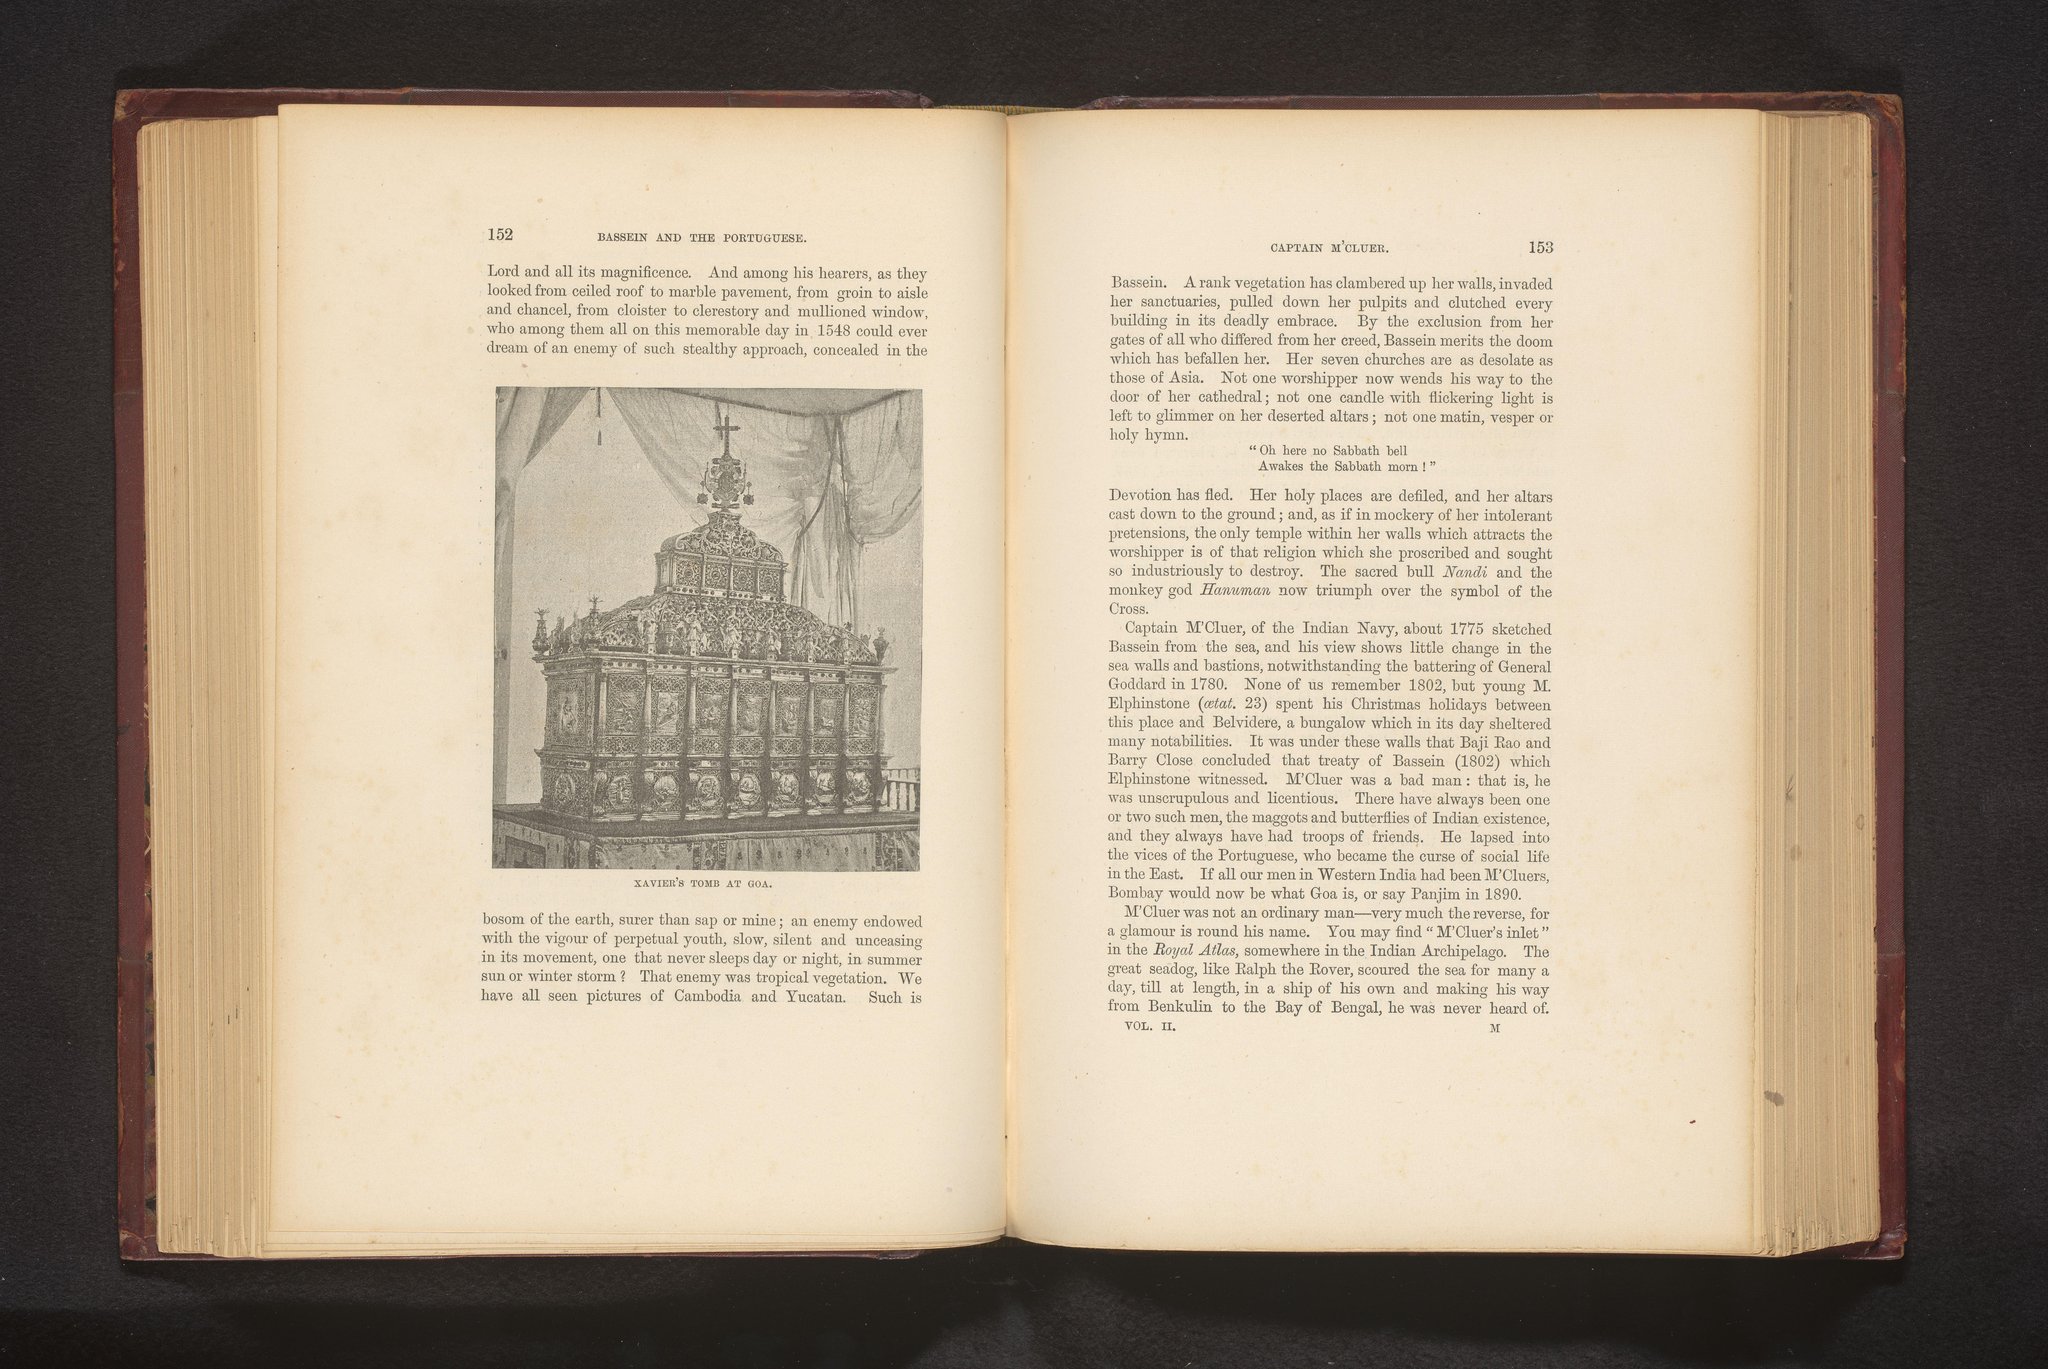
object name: page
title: Xavier's tomb at Goa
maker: Anonymous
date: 1883-1893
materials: paper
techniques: photolithography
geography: paris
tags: grave, tomb, interior of church